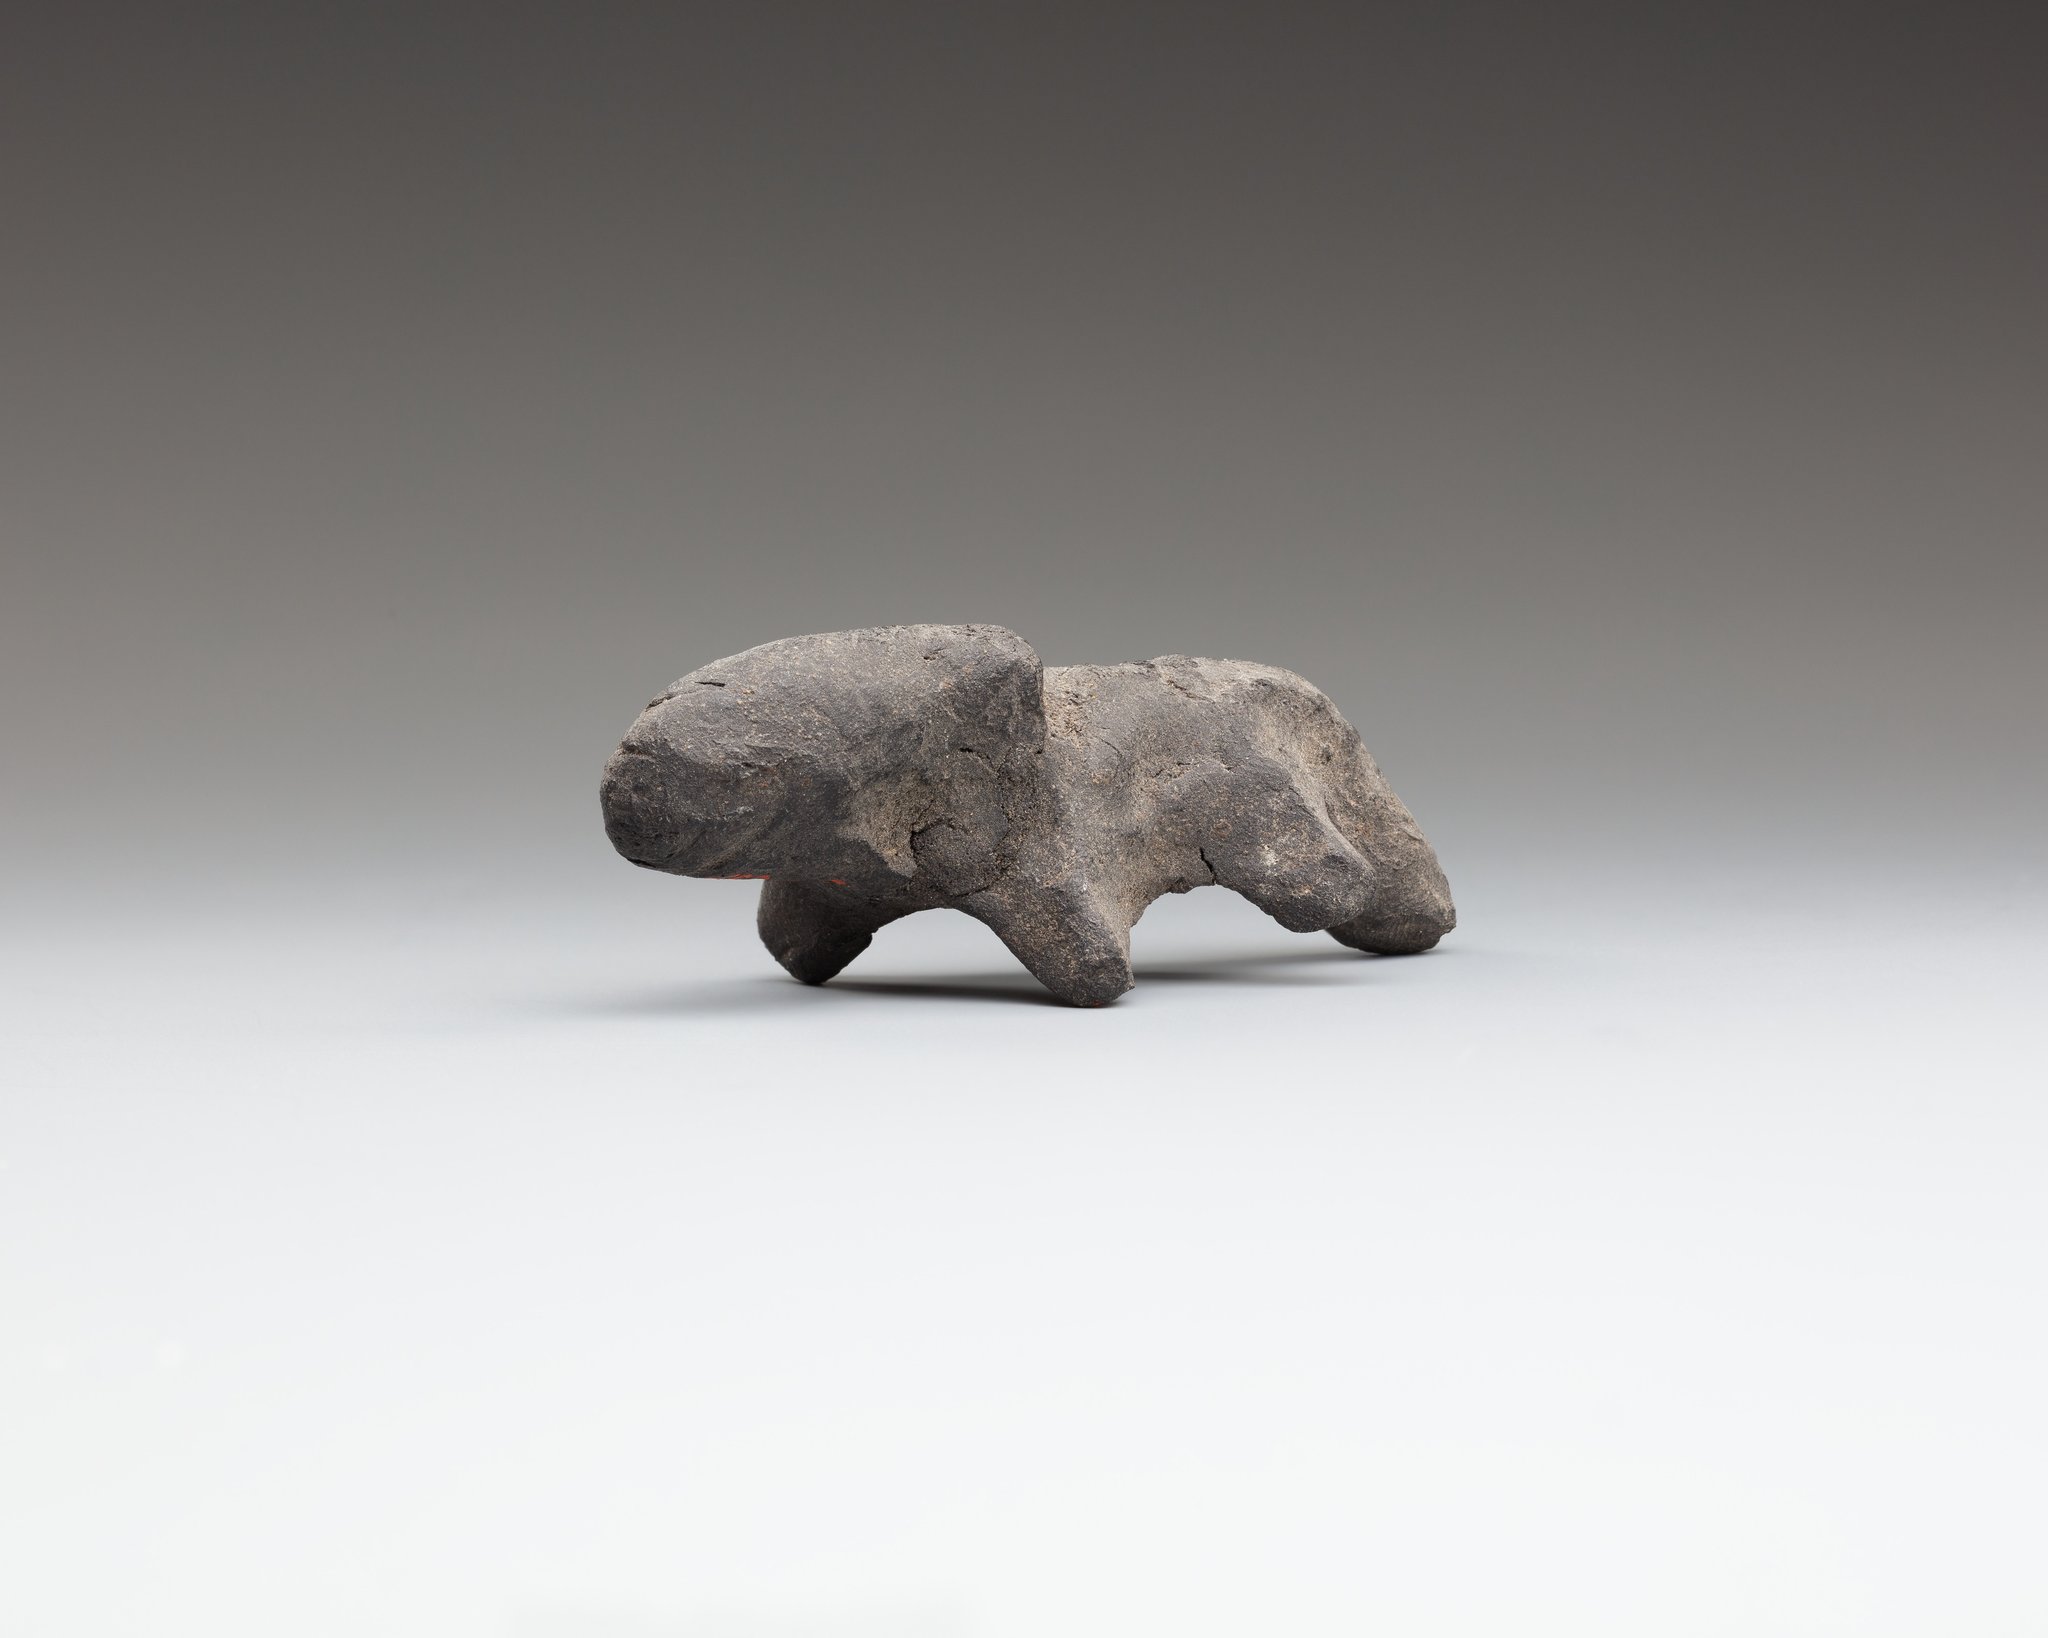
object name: figurine, animal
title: Animal figurine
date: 1981-1640 BCE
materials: clay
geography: egypt